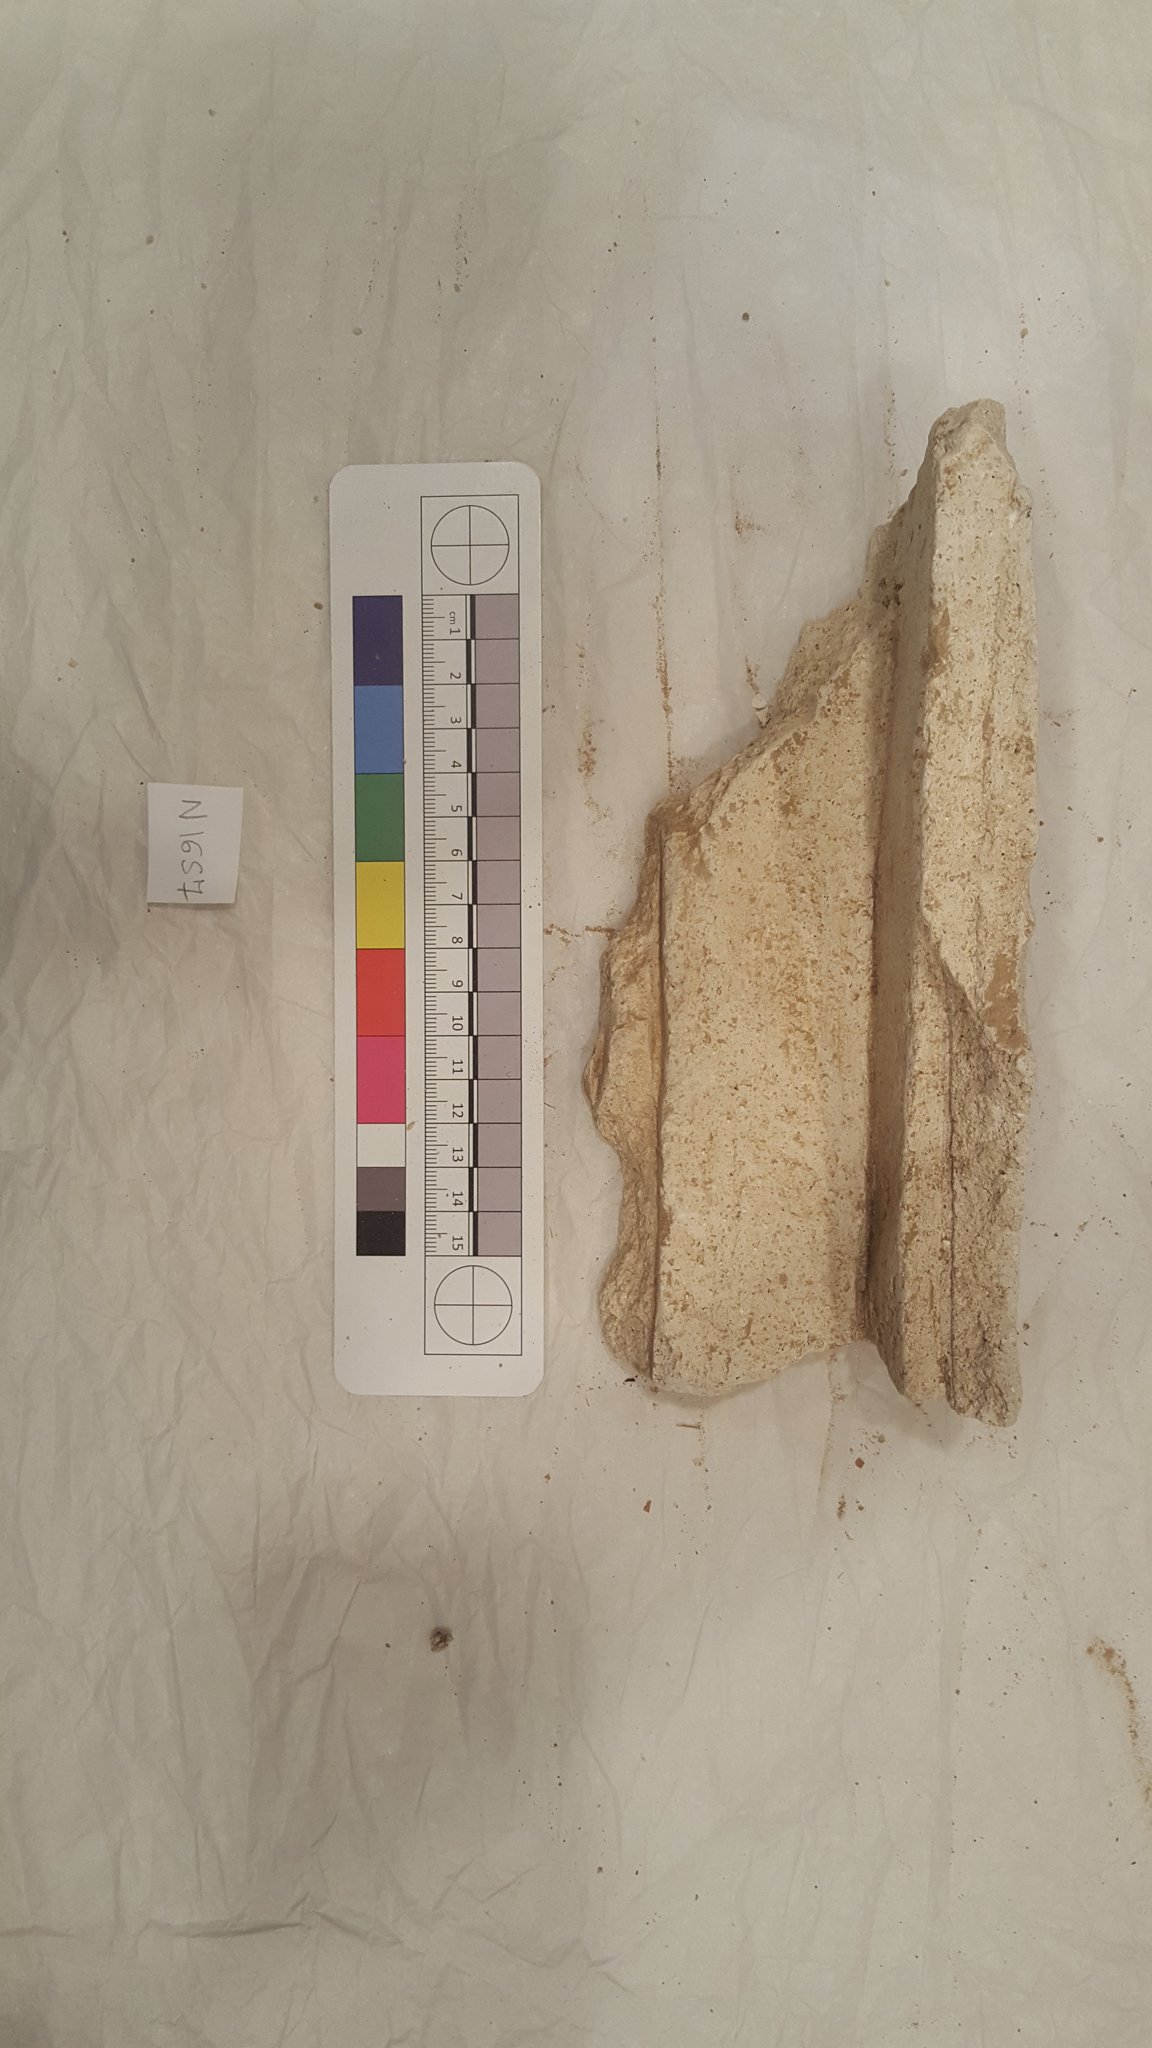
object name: fragment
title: Stucco Fragment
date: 701-1200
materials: plaster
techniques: carving, painting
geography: iran